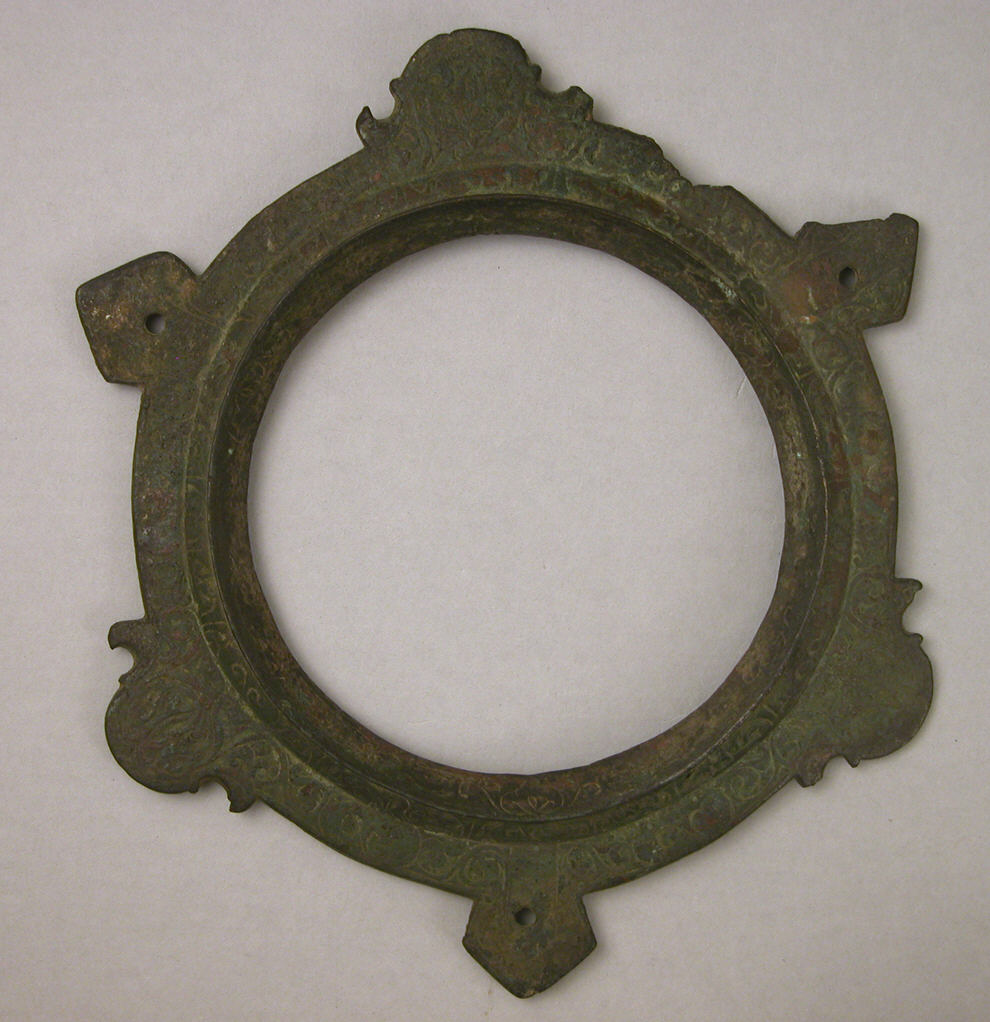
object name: rim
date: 1101-1200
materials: bronze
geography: iran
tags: arabic